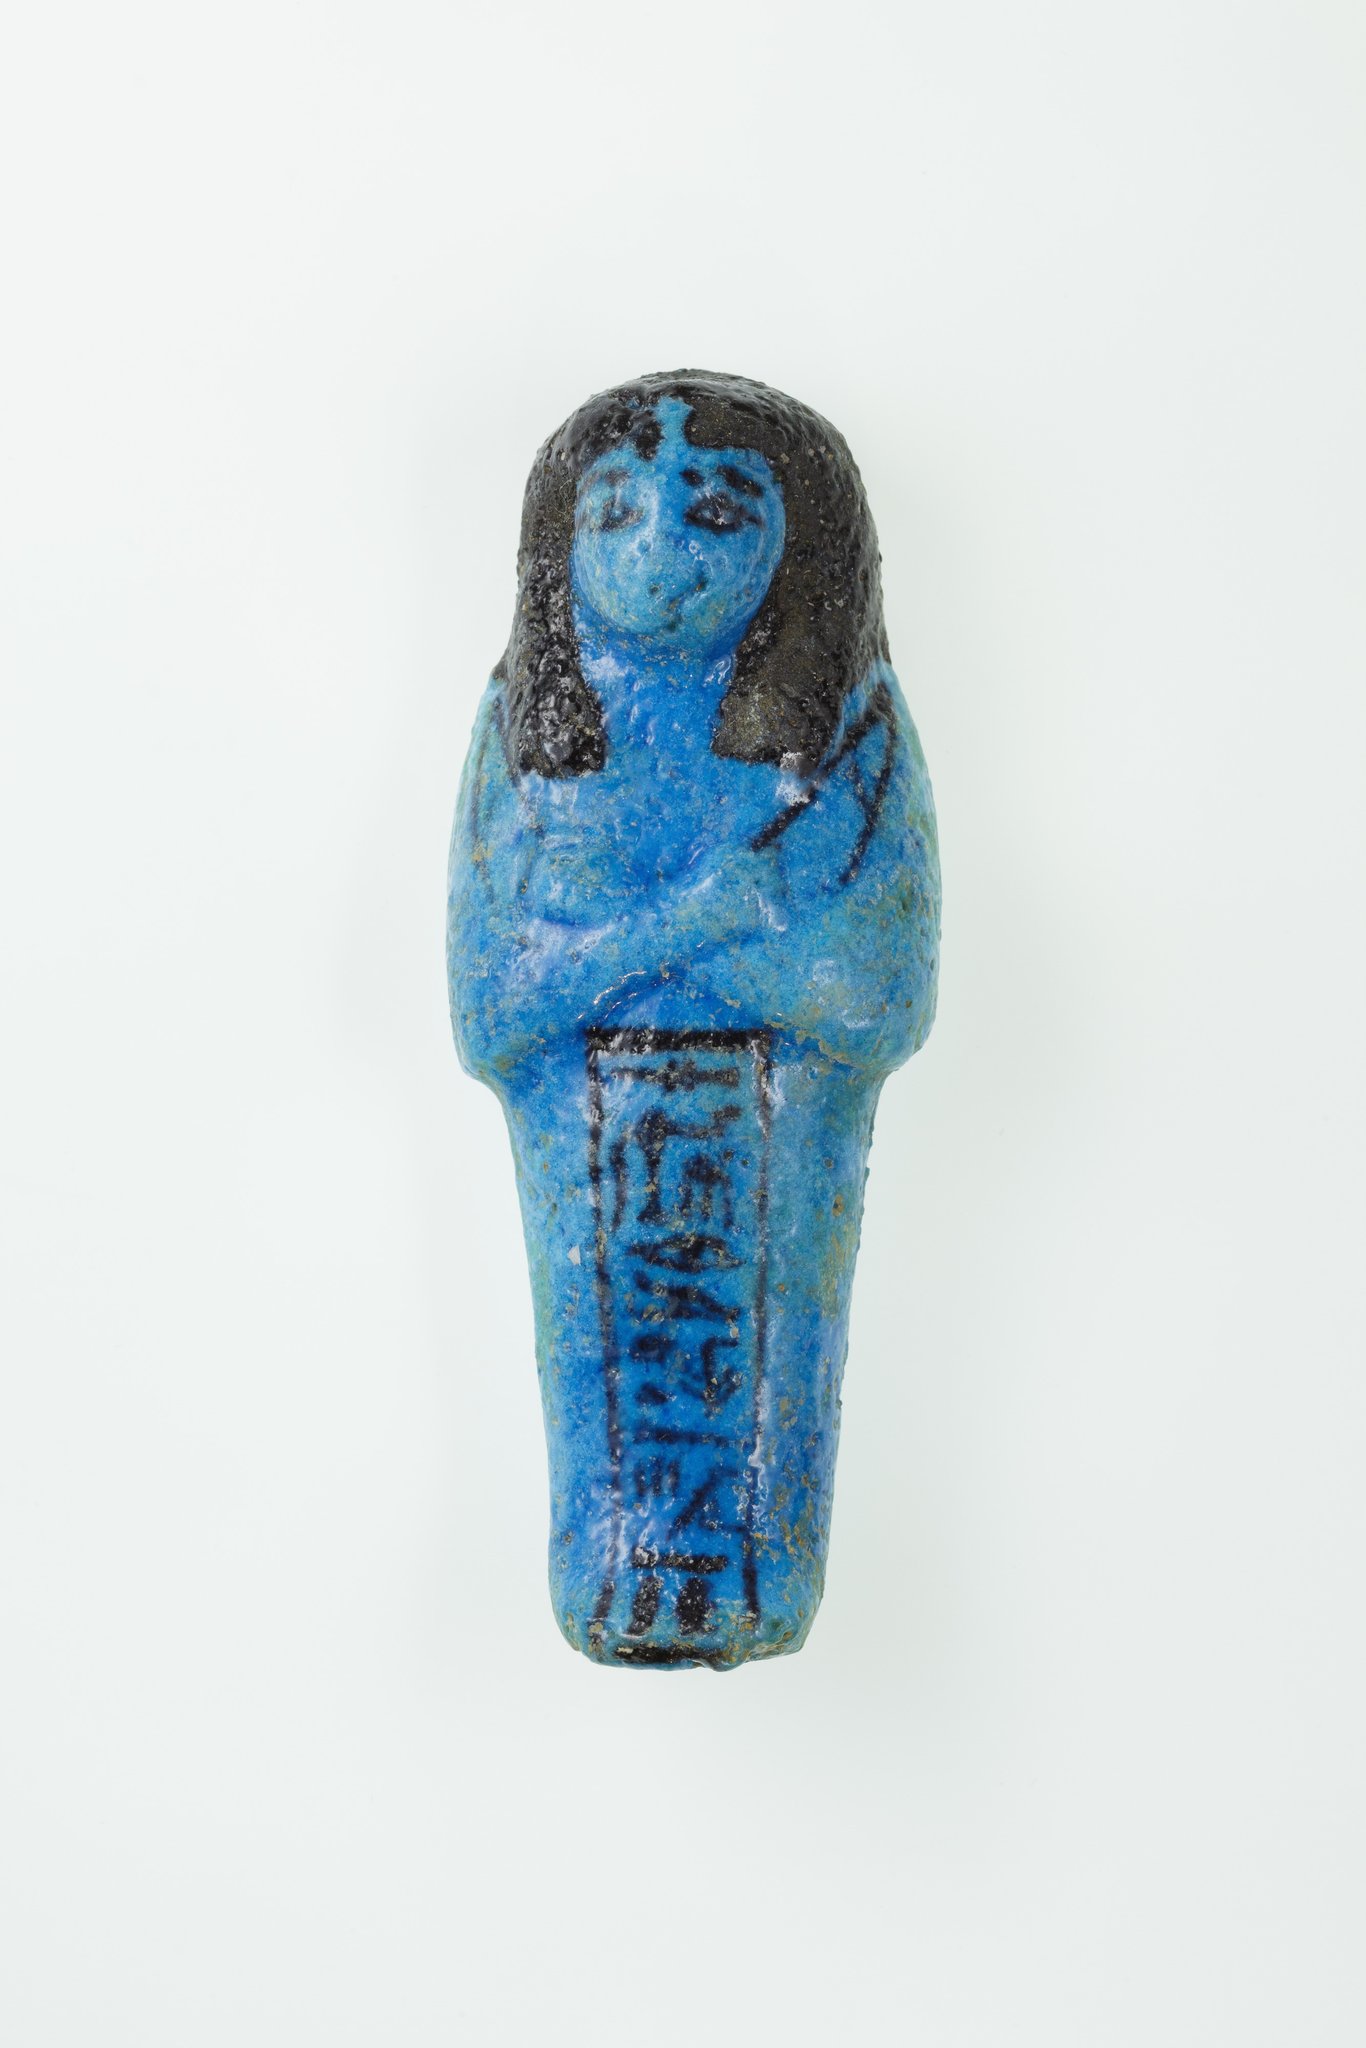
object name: shabti, worker, nauny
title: Worker Shabti of Nauny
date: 1050 BCE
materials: faience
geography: egypt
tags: hieroglyphs